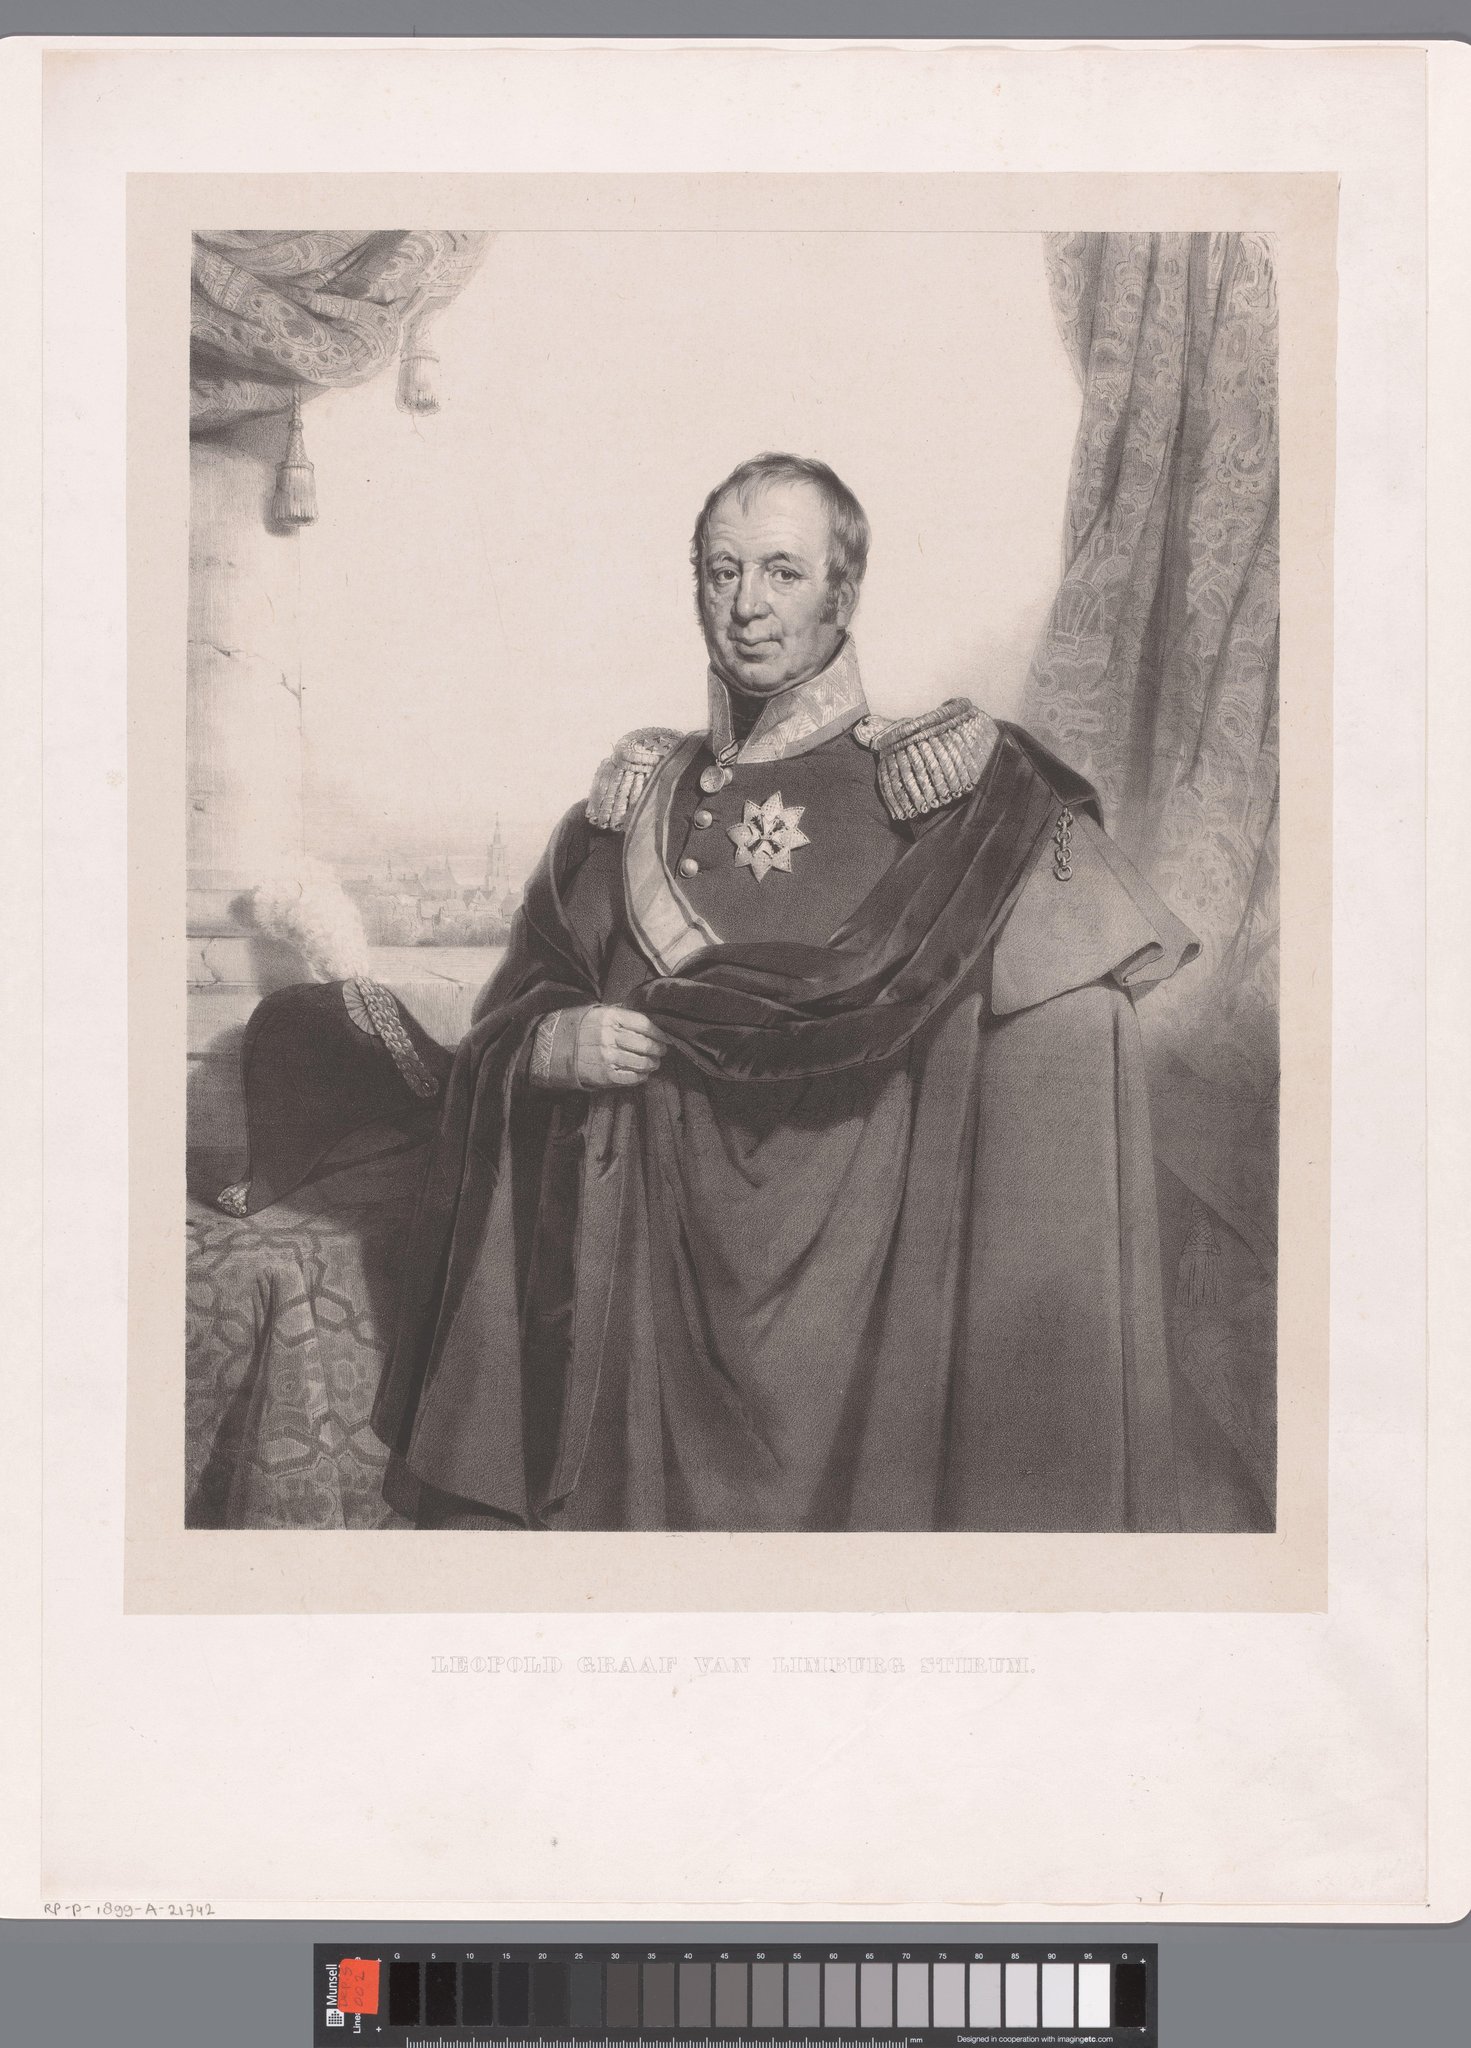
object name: print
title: Portret van Leopold van Limburg Stirum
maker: coenraad hamburger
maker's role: draughtsman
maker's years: 1809-1891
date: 1841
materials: paper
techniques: lithograph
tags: the hague, historical persons (+ three-quarter length portrait)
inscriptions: collector's mark: Lugt 2228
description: De geportretteerde draagt een militair kostuum met het grootkruis van de Militaire Willemsorde en een mantel. Hij staat voor een open raam.